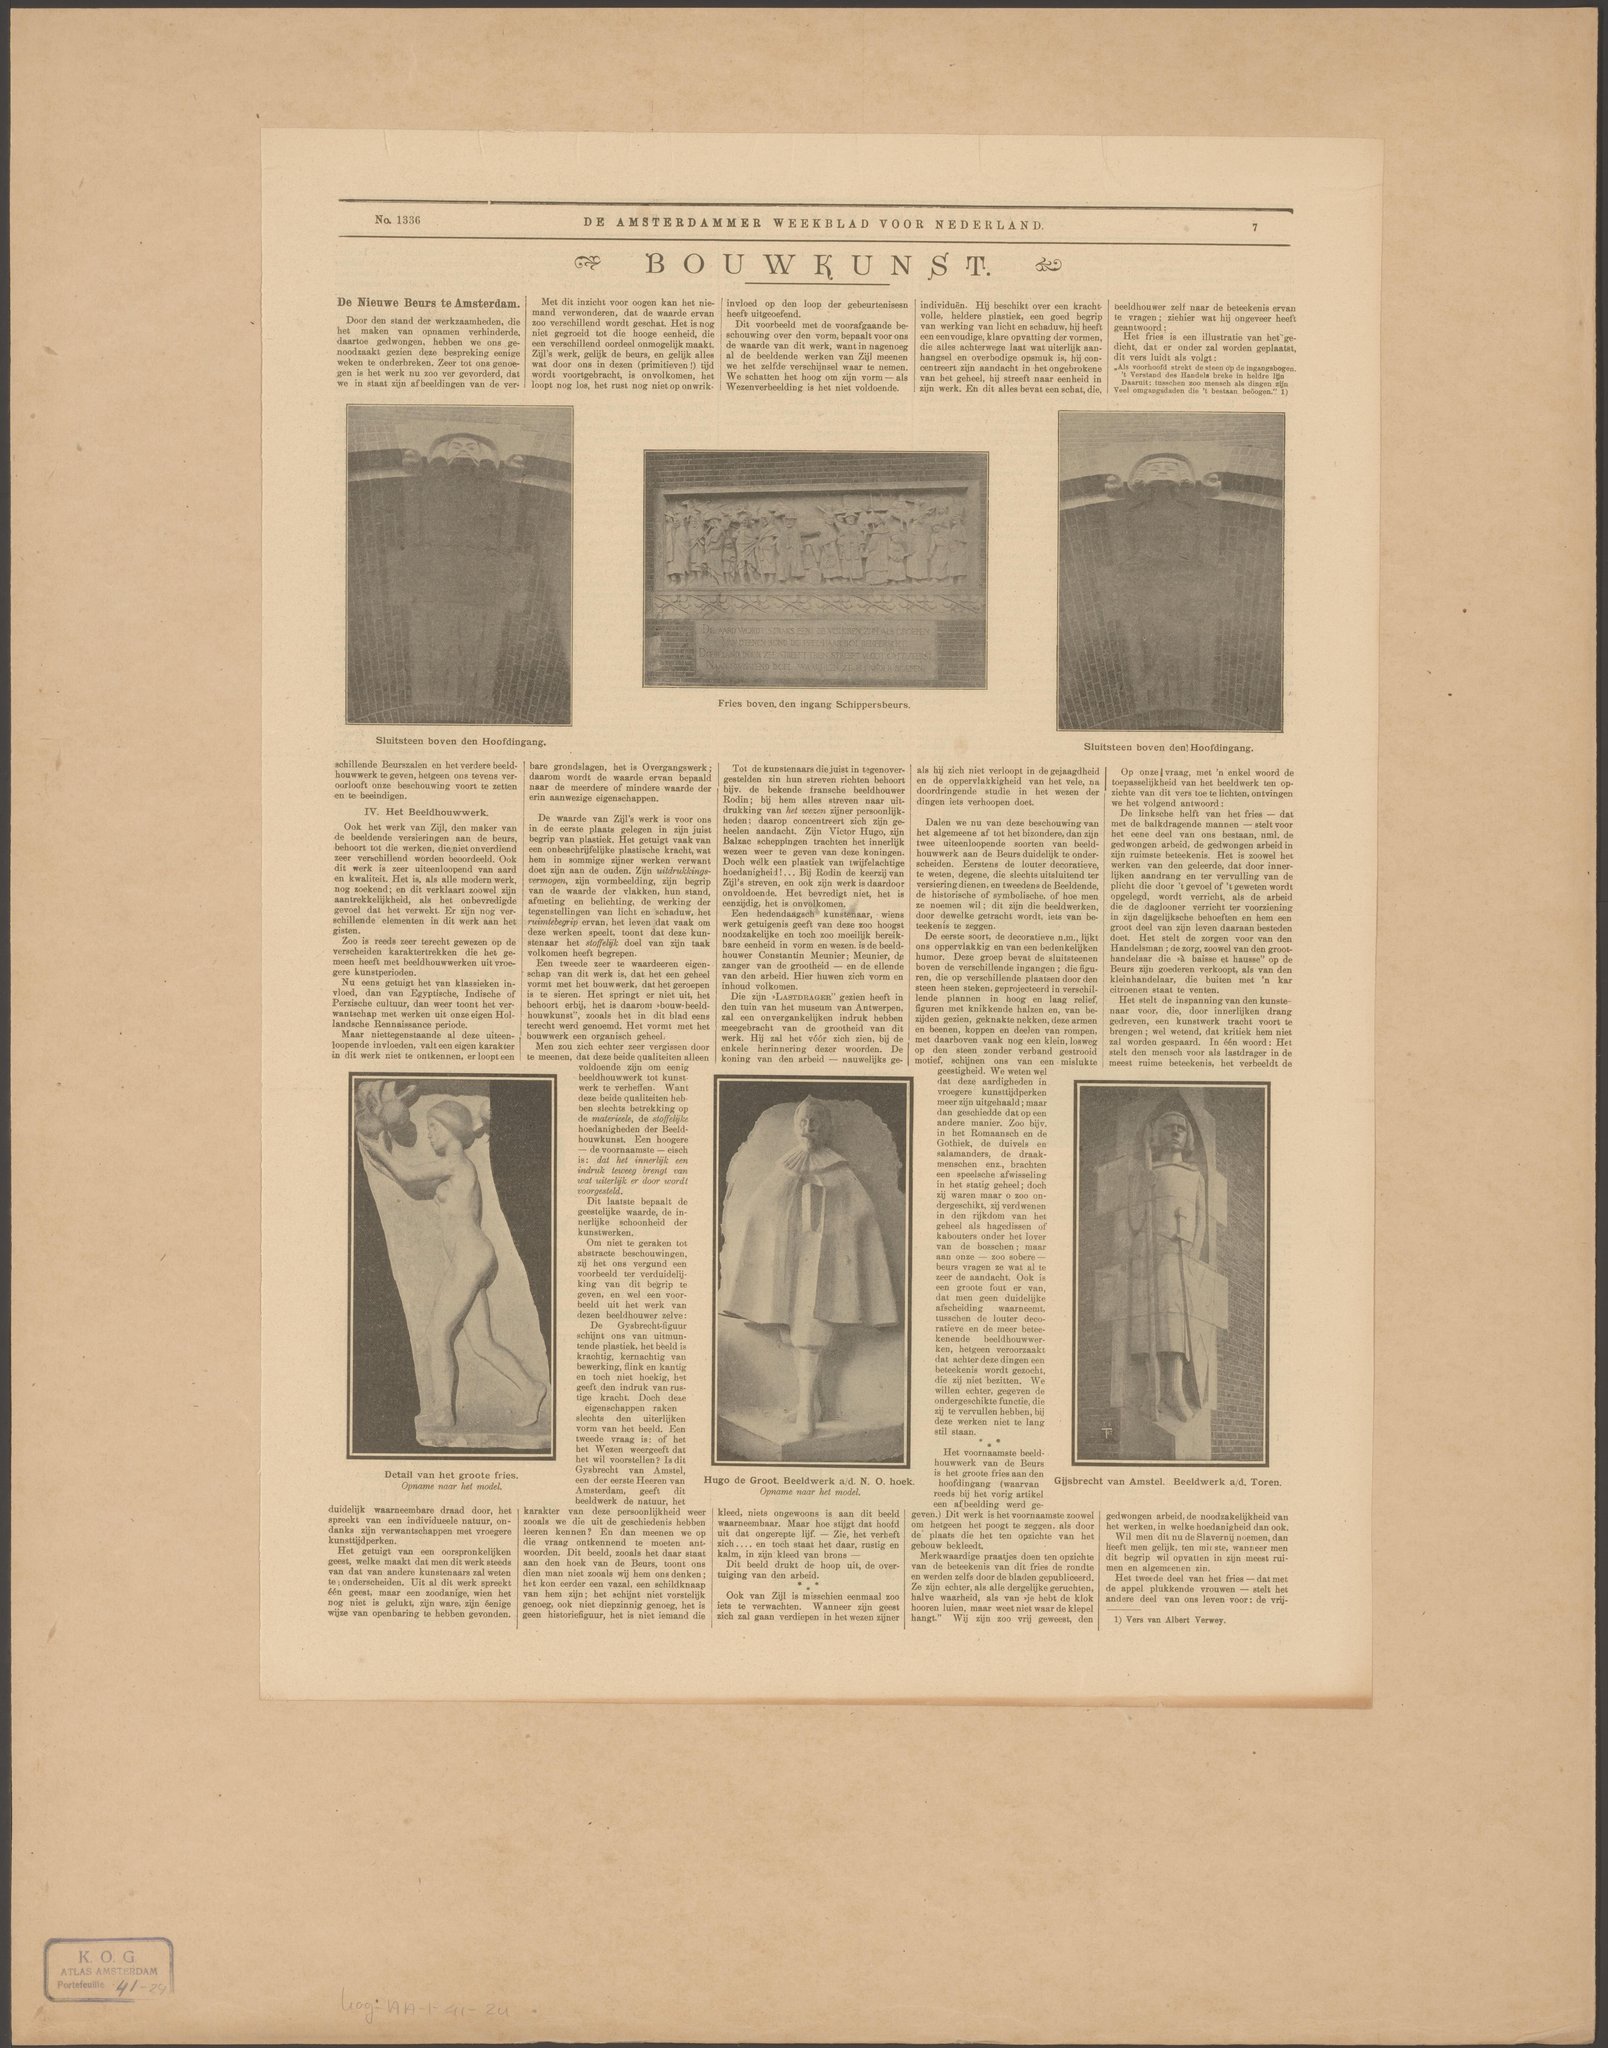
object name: photomechanical print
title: Reliëfs en beelden van de Beurs van Berlage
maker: Anonymous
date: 1903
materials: paper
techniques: letterpress printing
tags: stock exchange, stock-market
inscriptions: collector's mark: Lugt 1461b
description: Rechtsboven genummerd: 7. Onderwerpsrubriek binnen de Atlas Amsterdam: B. Beurs op het Damrak.